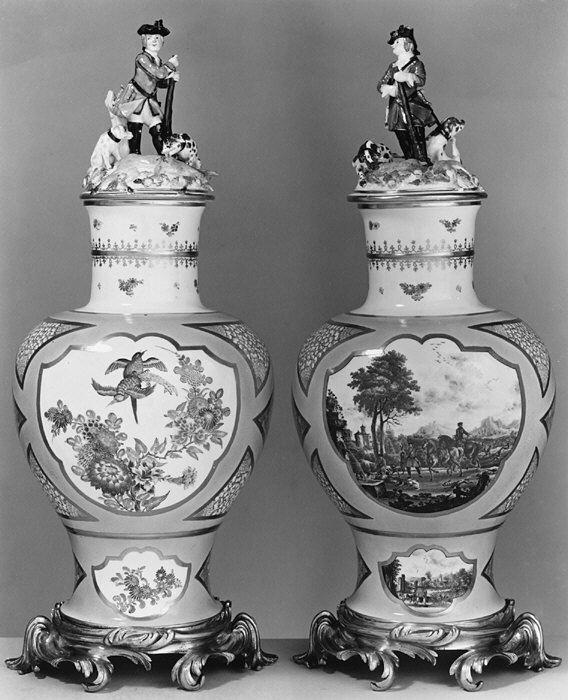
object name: vase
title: Vase (one of a pair)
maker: meissen manufactory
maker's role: manufactory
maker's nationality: german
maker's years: 1710-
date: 1740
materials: gilt bronze, hard paste porcelain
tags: birds,men,flowers,trees